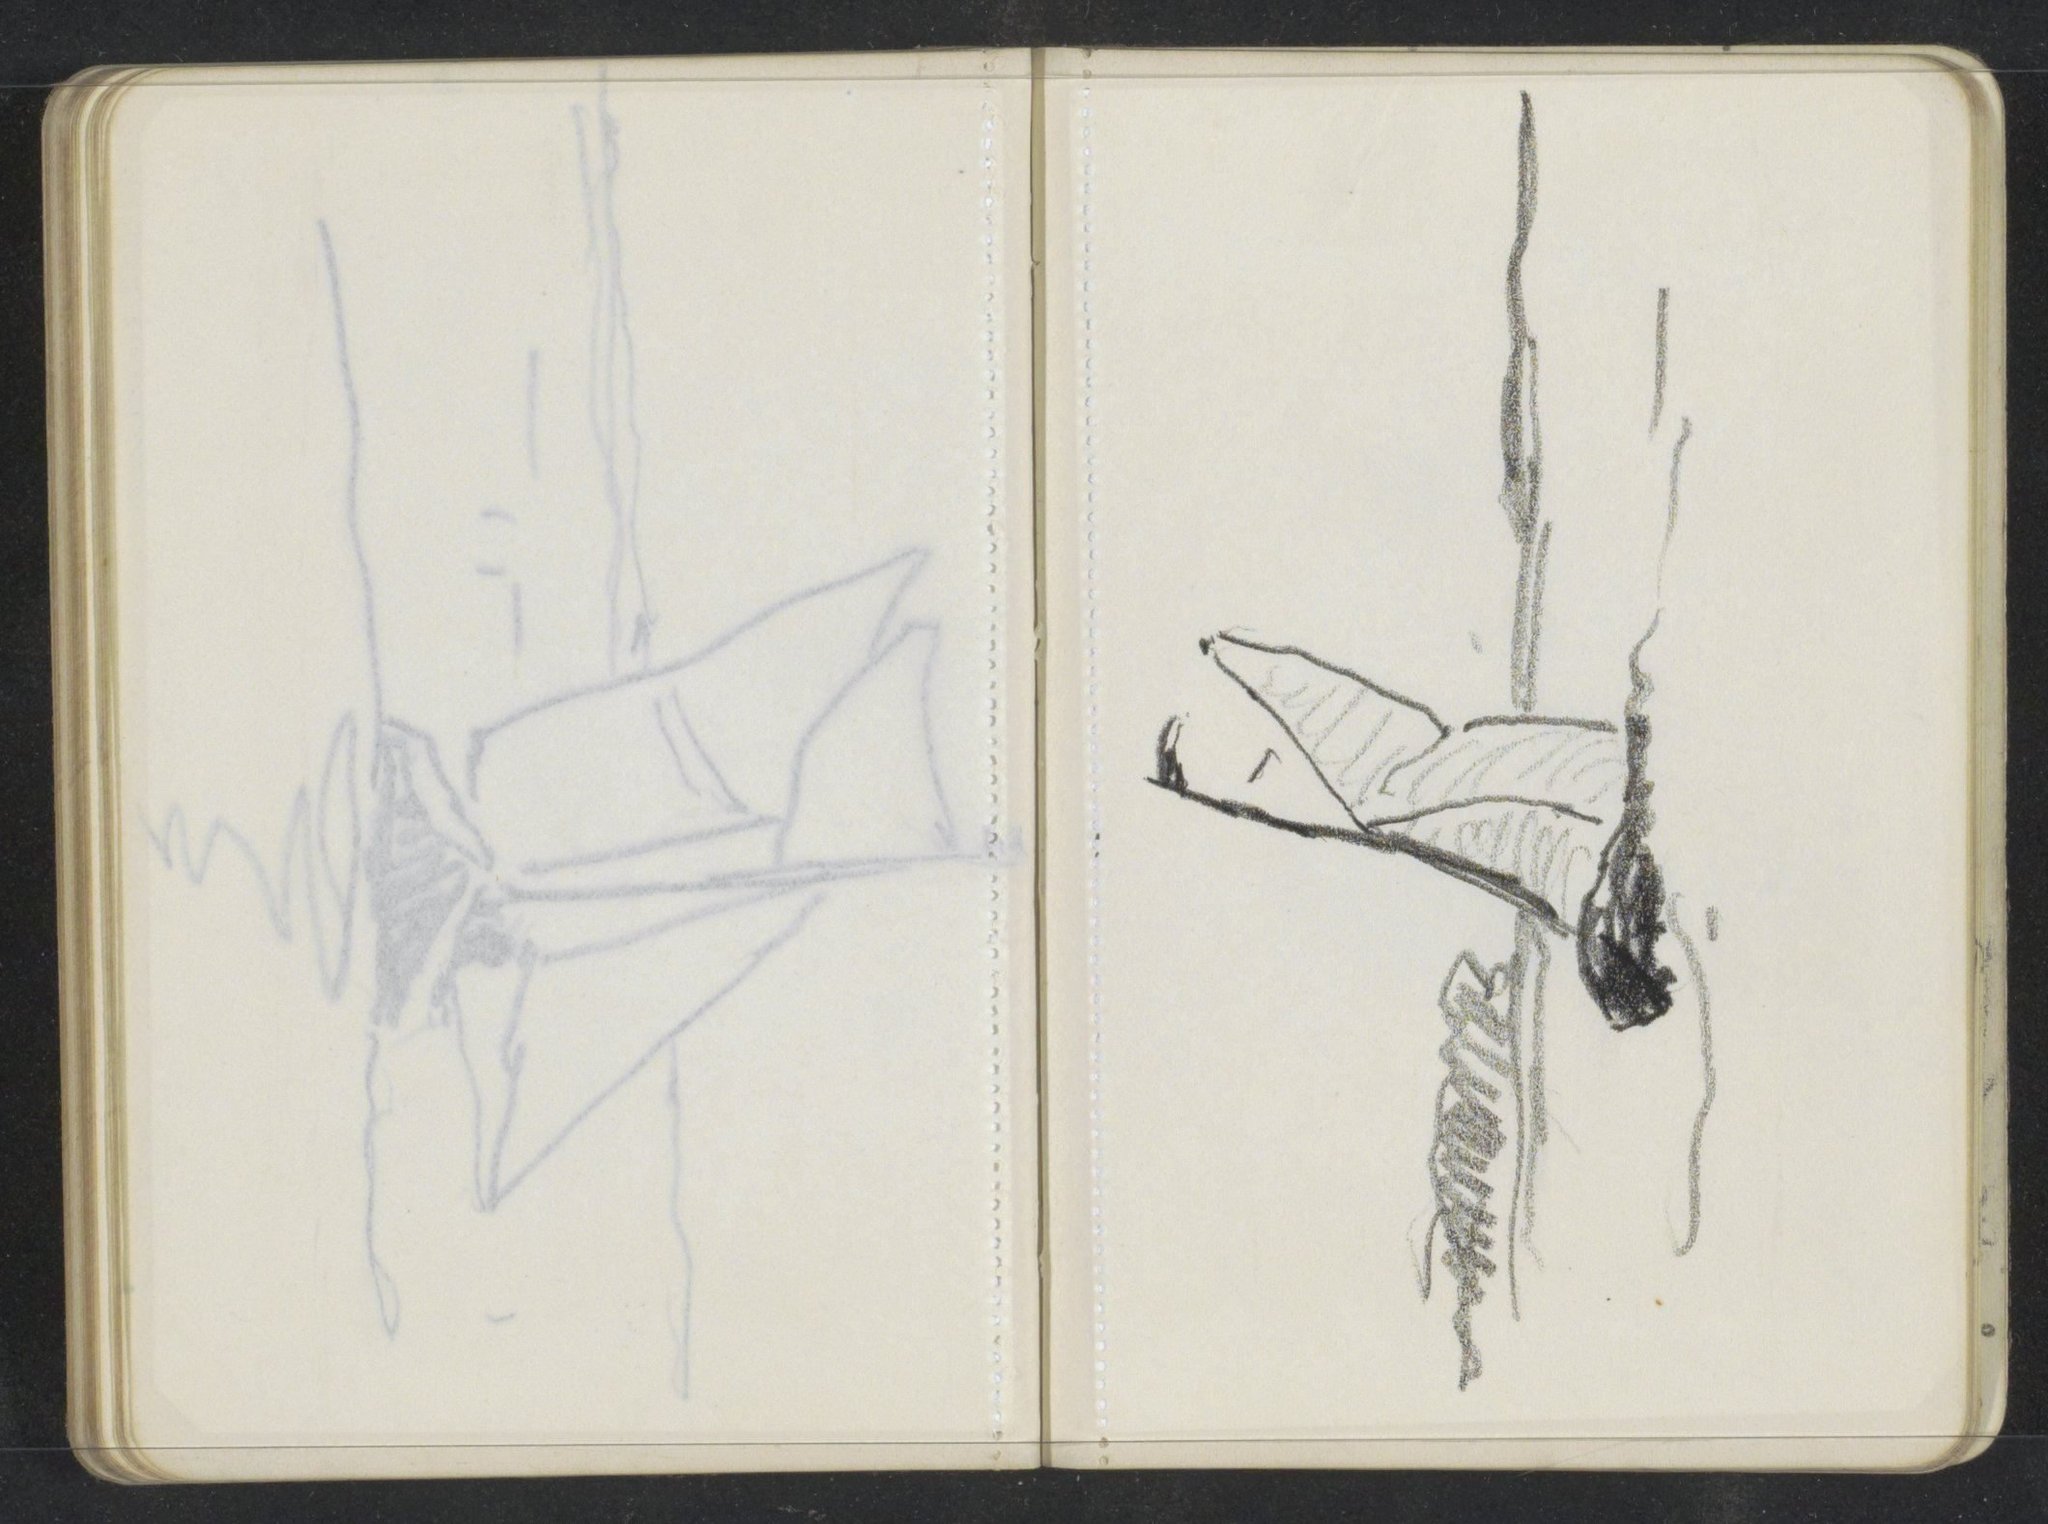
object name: sketchbook leaf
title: Zeilboot voor een kust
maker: alexander shilling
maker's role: draughtsman, print maker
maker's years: 1859-1937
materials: paper, pencil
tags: sailing-ship, sailing-boat, landscapes with waters, waterscapes, seascapes (in the temperate zone)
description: Blad 53 recto uit een schetsboek met 91 bladen.